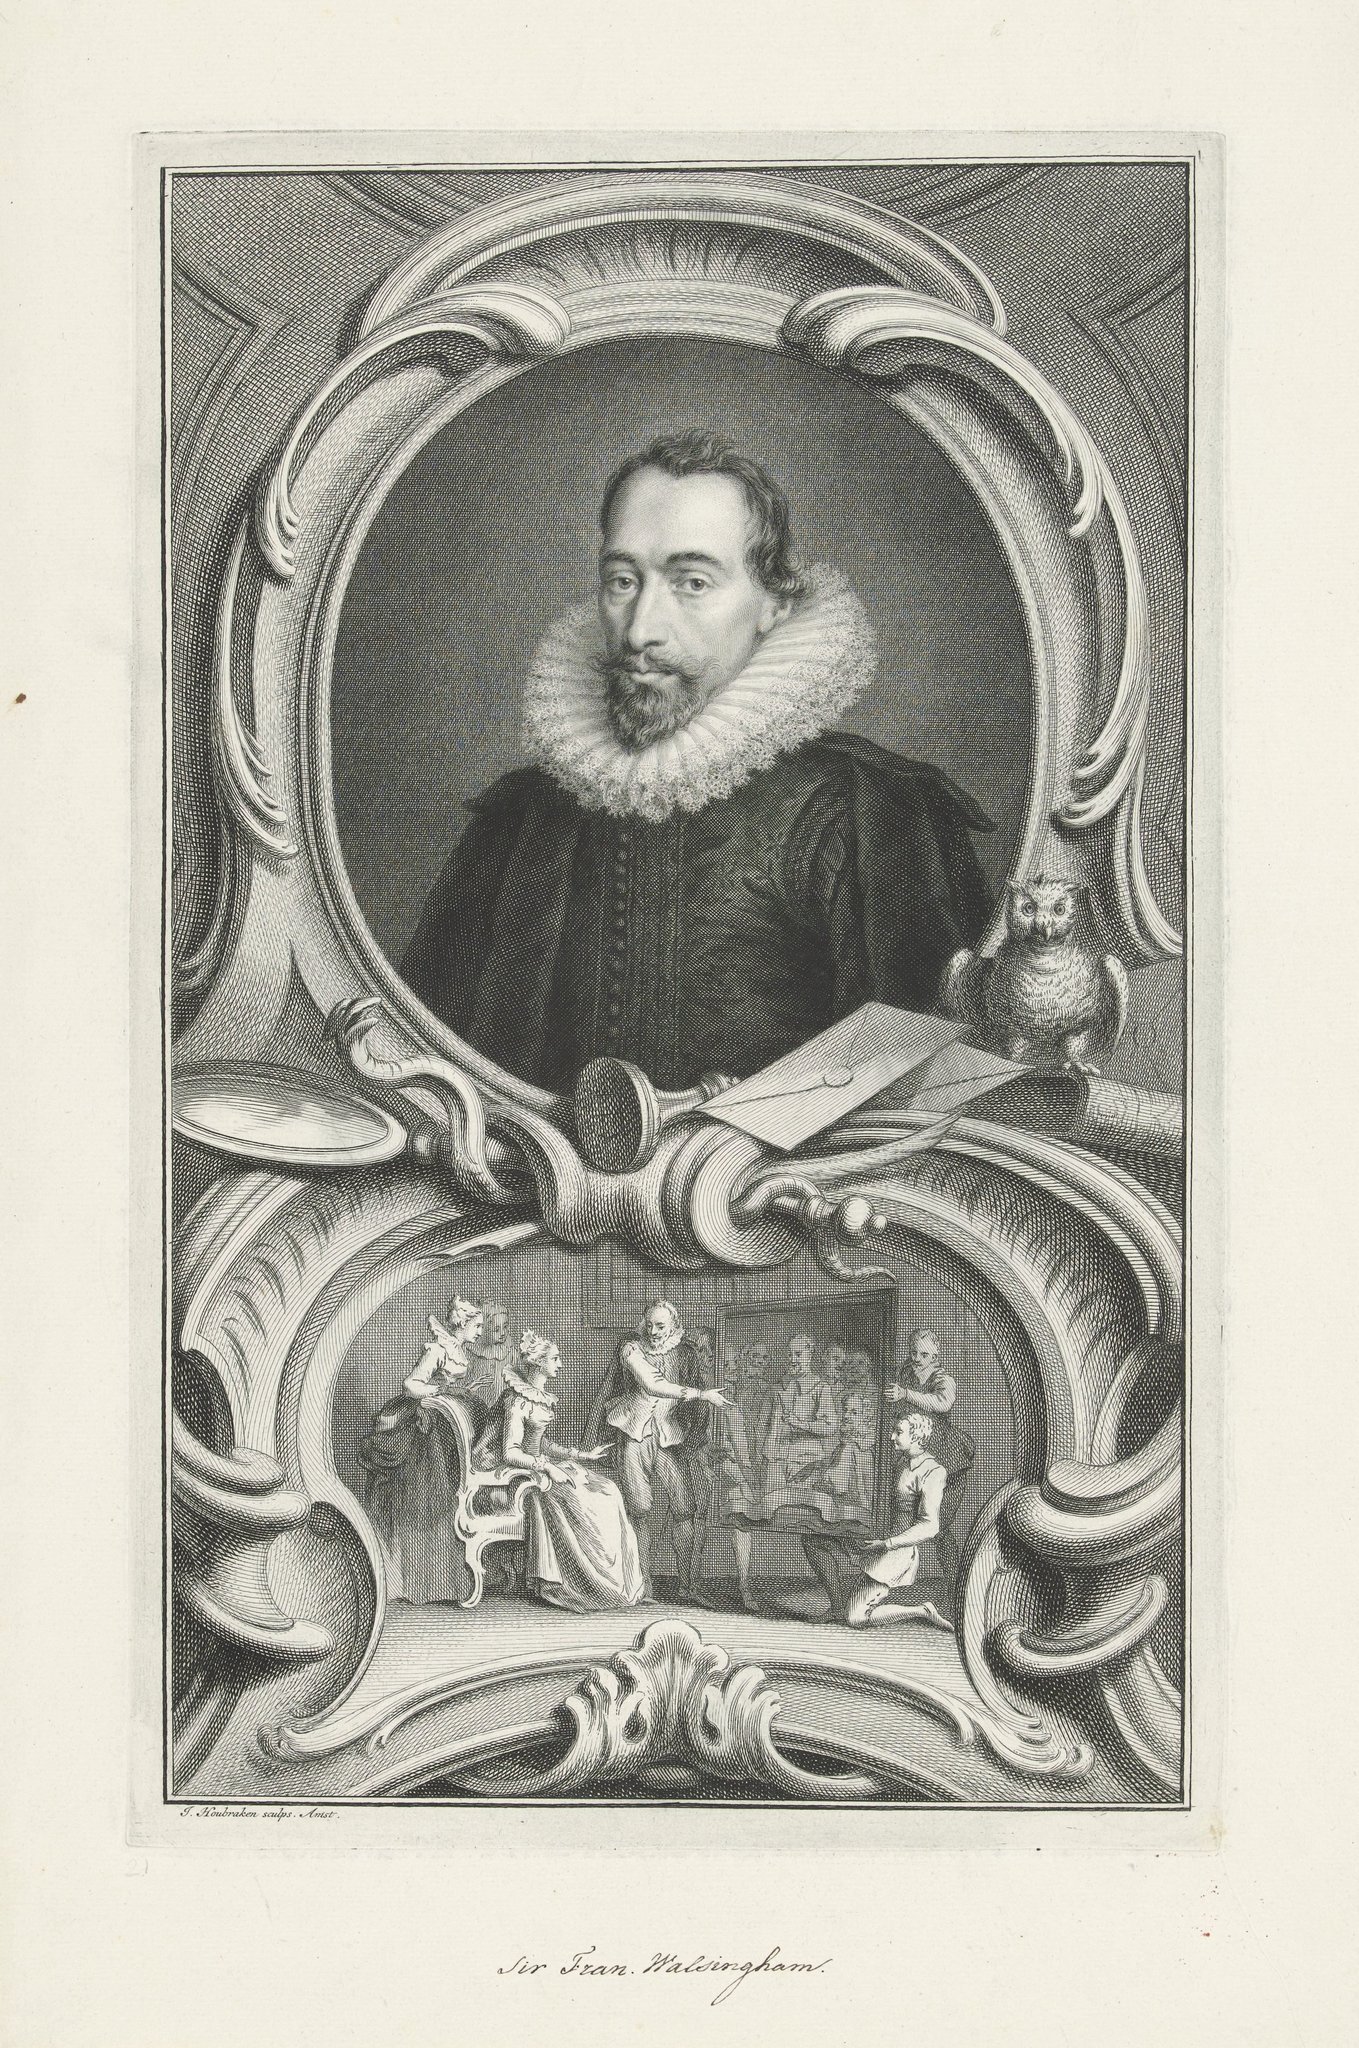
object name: print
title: Portret van Francis Walsingham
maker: jacob houbraken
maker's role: draughtsman, print maker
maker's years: 1698-1780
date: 1736-1738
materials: paper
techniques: engraving, etching, pen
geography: amsterdam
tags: hendrik iii (koning van frankrijk), london, françois-hercule de valois (hertog van anjou)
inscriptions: name: ‘Sir Fran. Walsingham’, collector's mark: Lugt 240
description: Prent ook gebruikt in: Thomas Birch. The heads of illustrious persons of Great Britain : engraved by Houbraken, and Vertue, with their lives and characters. London: John en Paul Knapton, 1743-1751.